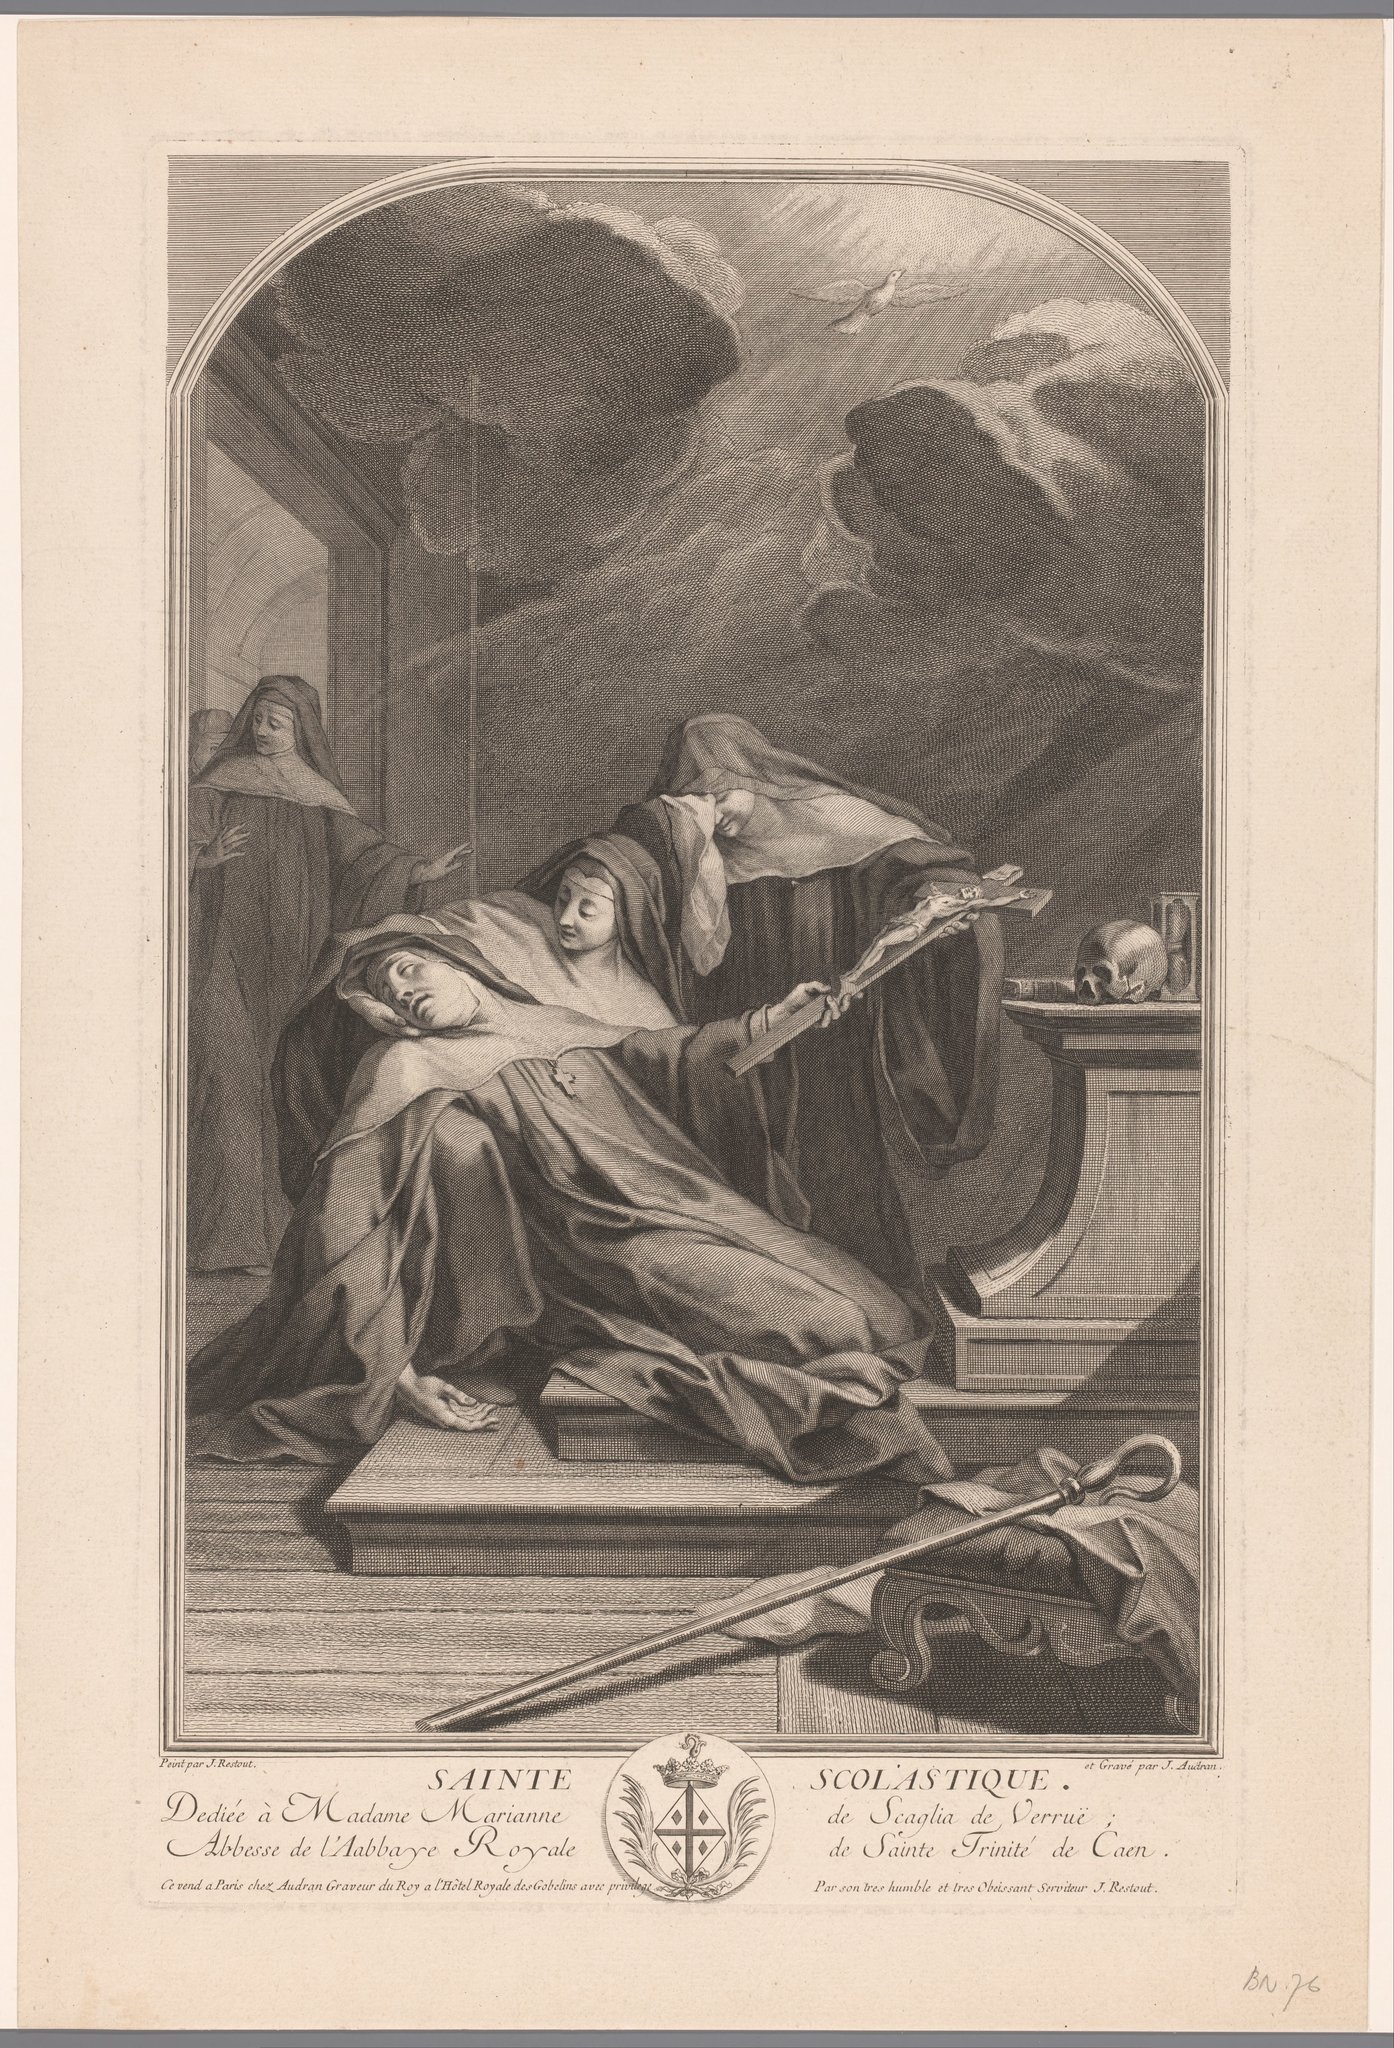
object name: print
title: Dood van H. Scholastica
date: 1702-1756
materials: paper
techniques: etching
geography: paris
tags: martyrdom, suffering, misfortune, death of st. scholastica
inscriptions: collector's mark: Lugt 240